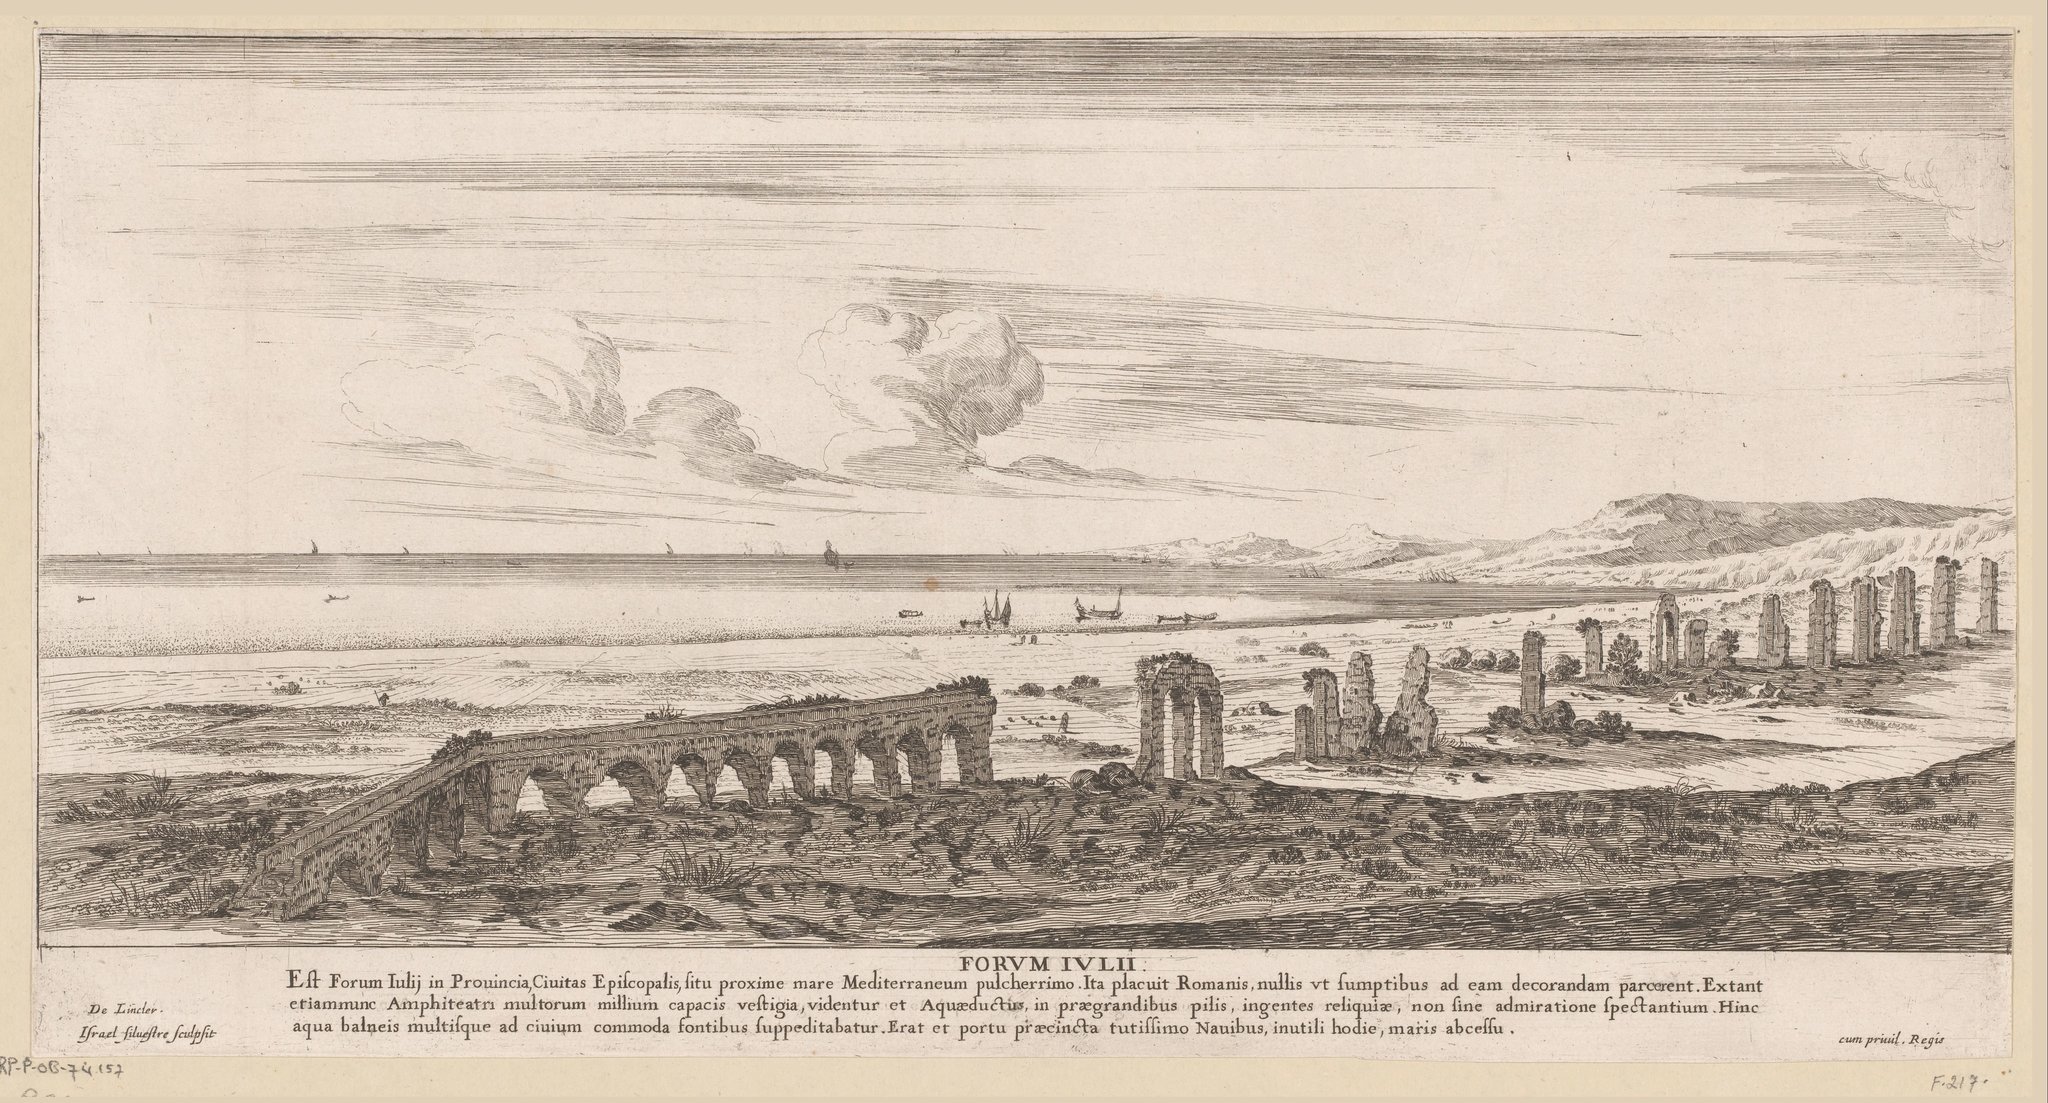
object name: print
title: Gezicht op het forum Julius bij Fréjus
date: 1631-1691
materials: paper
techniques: engraving, etching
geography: france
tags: city-view, and landscape with man-made constructions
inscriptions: collector's mark: Lugt 240